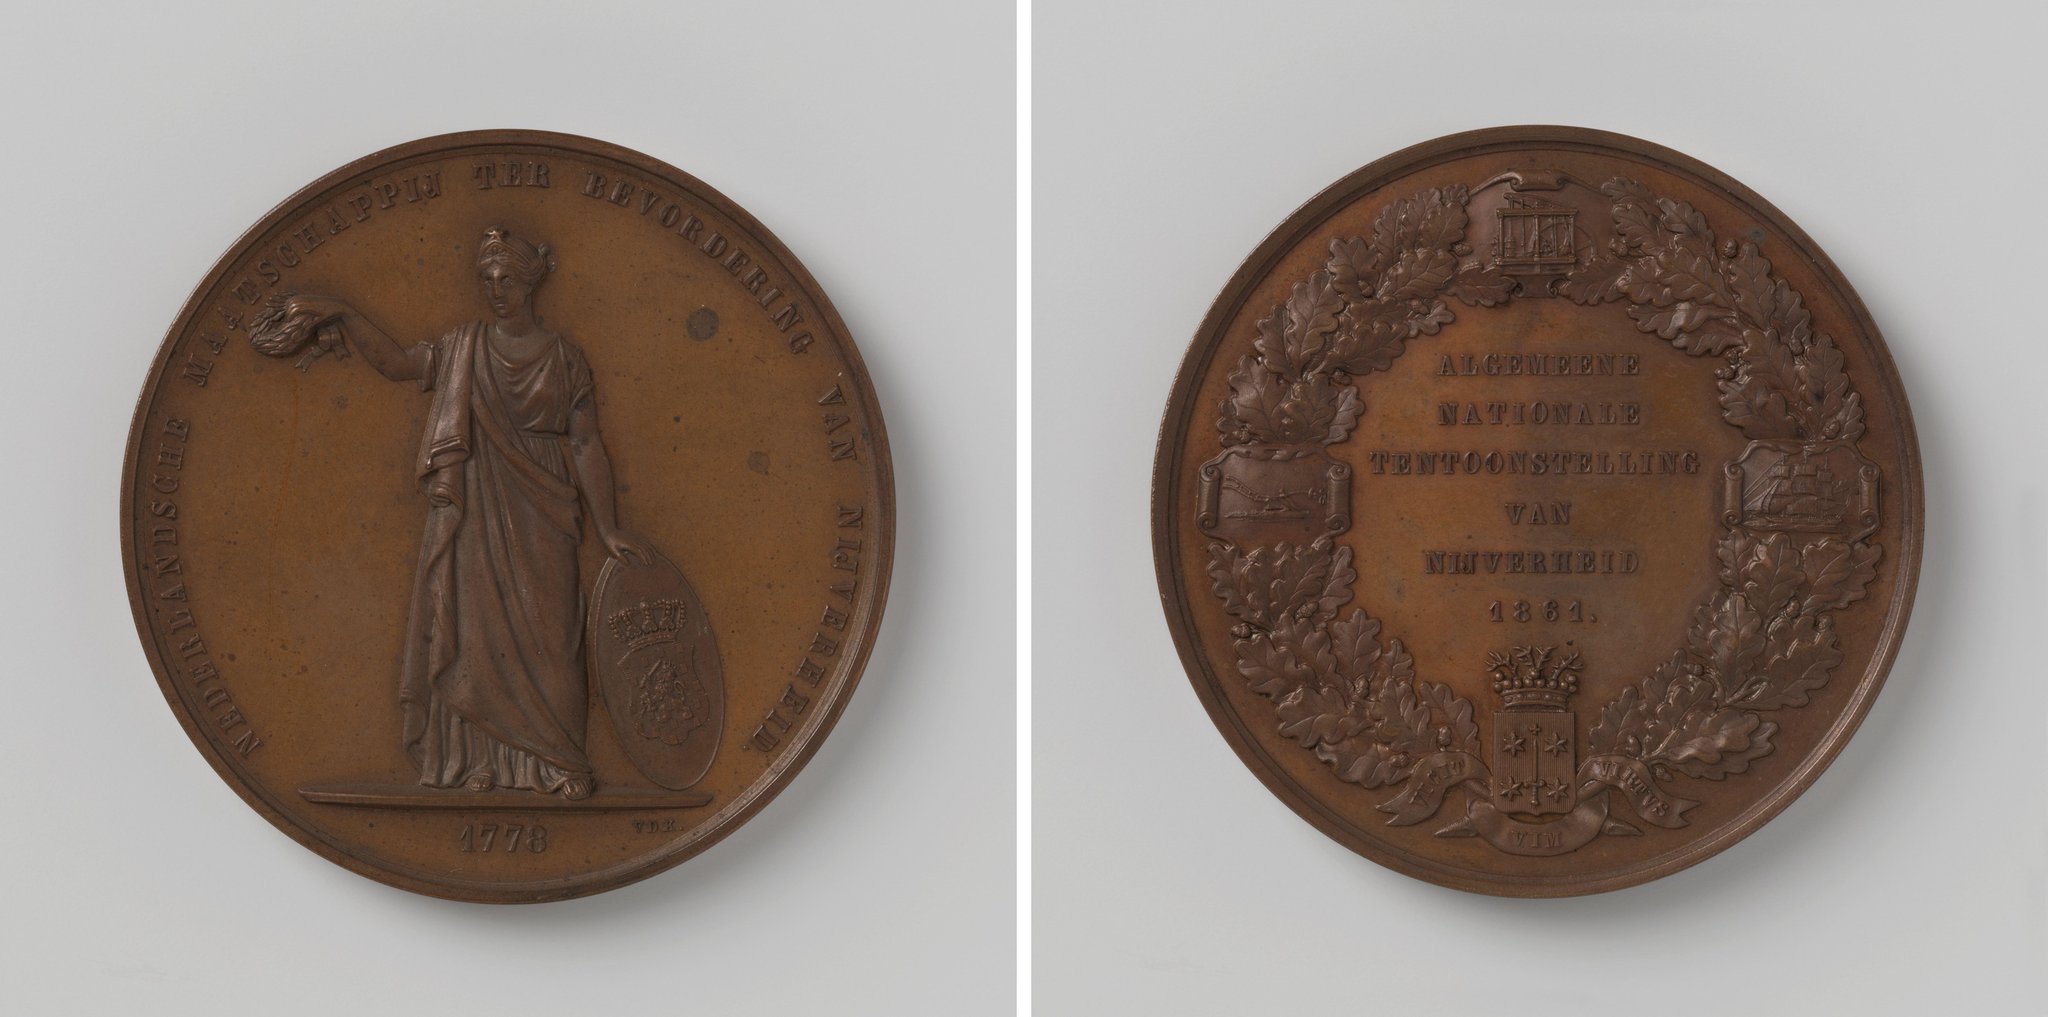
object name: medal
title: Algemeene Nationale tentoonstelling van Nijverheid te Haarlem, georganiseerd door de Maatschappij ter bevordering van Nijverheid, voorheen de Oeconomische Tak van de Hollandsche Maatschappij der Wetenschappen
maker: david van der kellen (1804-1879)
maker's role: die cutter, draughtsman, print maker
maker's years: 1804-1879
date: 1861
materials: bronze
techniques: striking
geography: utrecht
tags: haarlem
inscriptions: date: ‘1778’, signature: ‘V.D.K.’, circumscription: ‘NEDERLANDSCHE MAATSCHAPPIJ TER BEVORDERING VAN NIJVERHEID’, inscription: ‘ALGEMEENE NATIONALE TENTOONSTELLING VAN NIJVERHEID 1861’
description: Bronzen penning. Voorzijde: vrouw in Romeinse kledij met diadeem op hoofd, voorstellende Nijverheid, houdt in haar uitgestrekte rechterhand een lauwerkrans en rust met haar andere hand op een wapenschild binnen omschrift; afsnede: jaartal en signatuur. Keerzijde: opschrift boven gekroond wapenschild binnen eikekrans, waaraan drie cartouches zijn bevestigd met daarin een ploeg, een driemaster en een stoommachine.